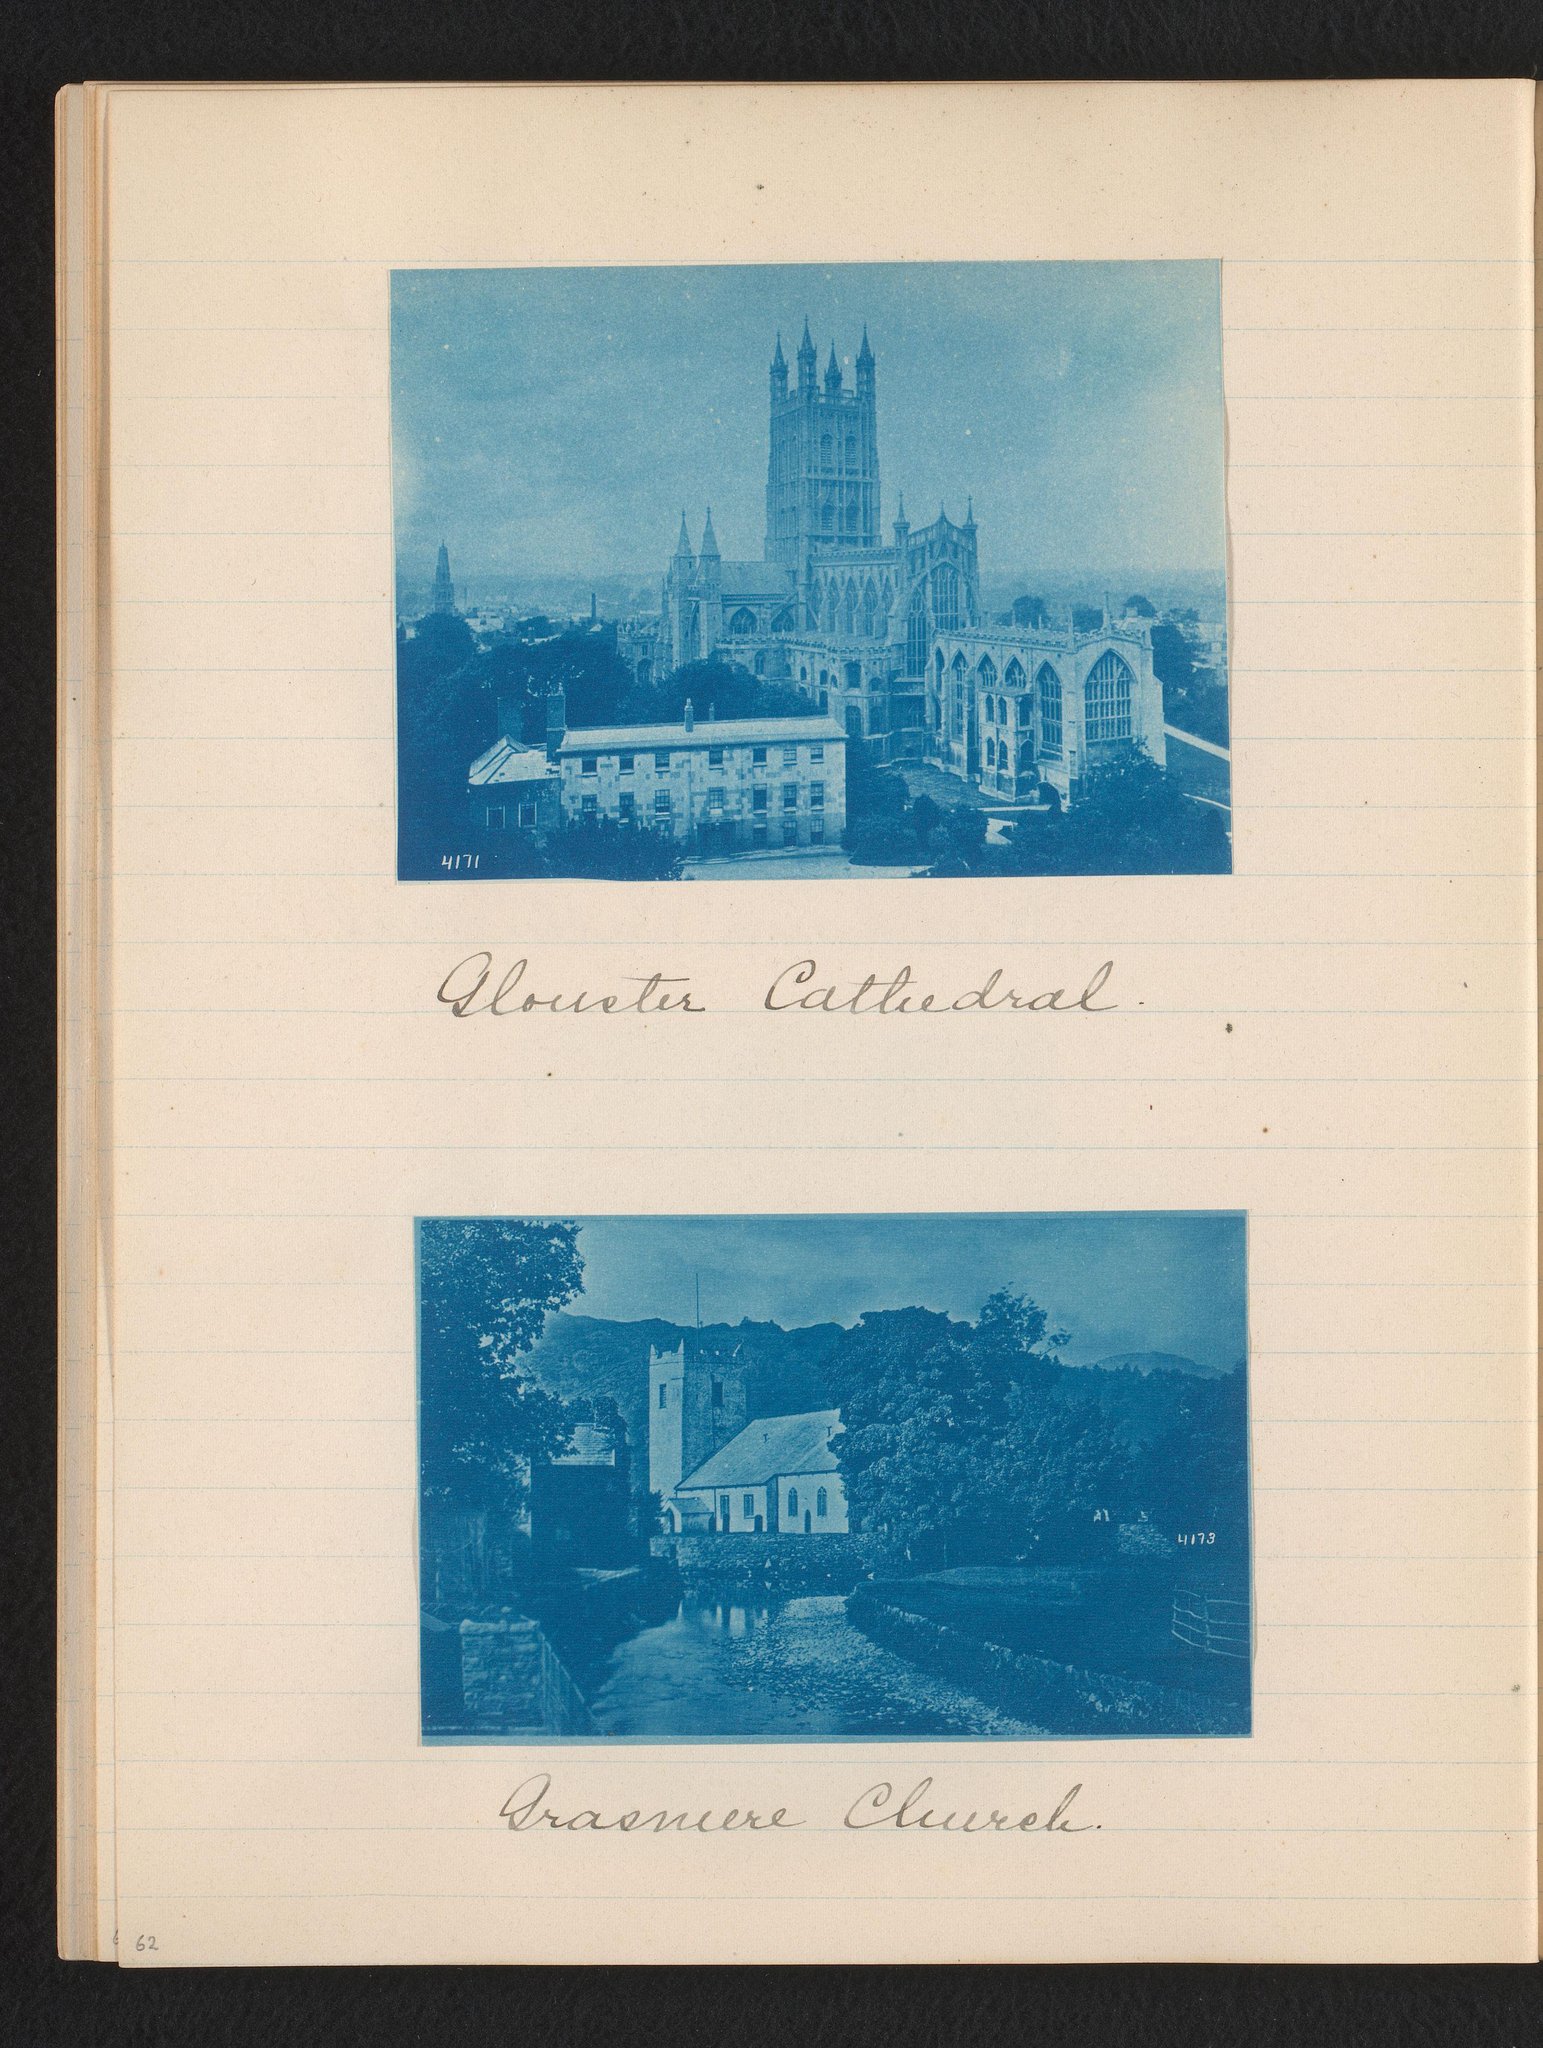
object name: photograph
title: Twee foto's van de kathedraal van Gloucester en de kerk van Grasmere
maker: Anonymous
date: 1901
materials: paper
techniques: cyanotype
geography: england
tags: church (exterior)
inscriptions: inscription: ‘Glouster Cathedral./ Grasmere Church.’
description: Deze foto's maken deel uit van een album.